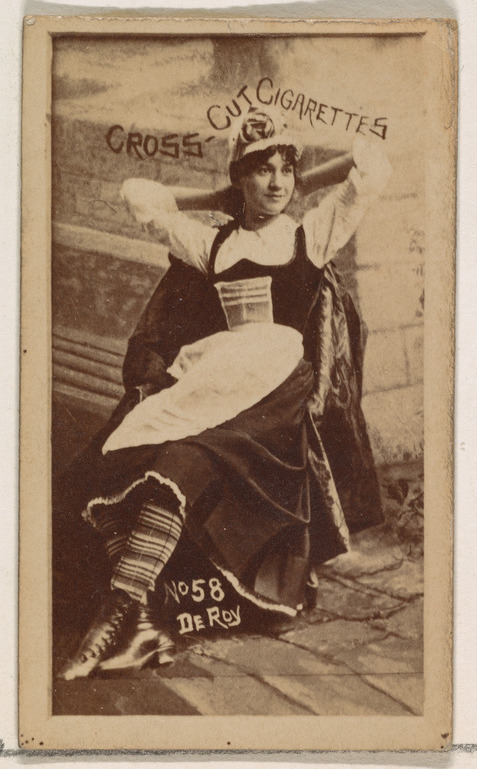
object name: print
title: Card Number 58, DeRoy, from the Actors and Actresses series (N145-1) issued by Duke Sons & Co. to promote Cross Cut Cigarettes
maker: w. duke, sons & co.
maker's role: publisher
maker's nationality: american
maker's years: 1870-1920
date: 1880-1889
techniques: albumen silver print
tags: portraits,women,actresses